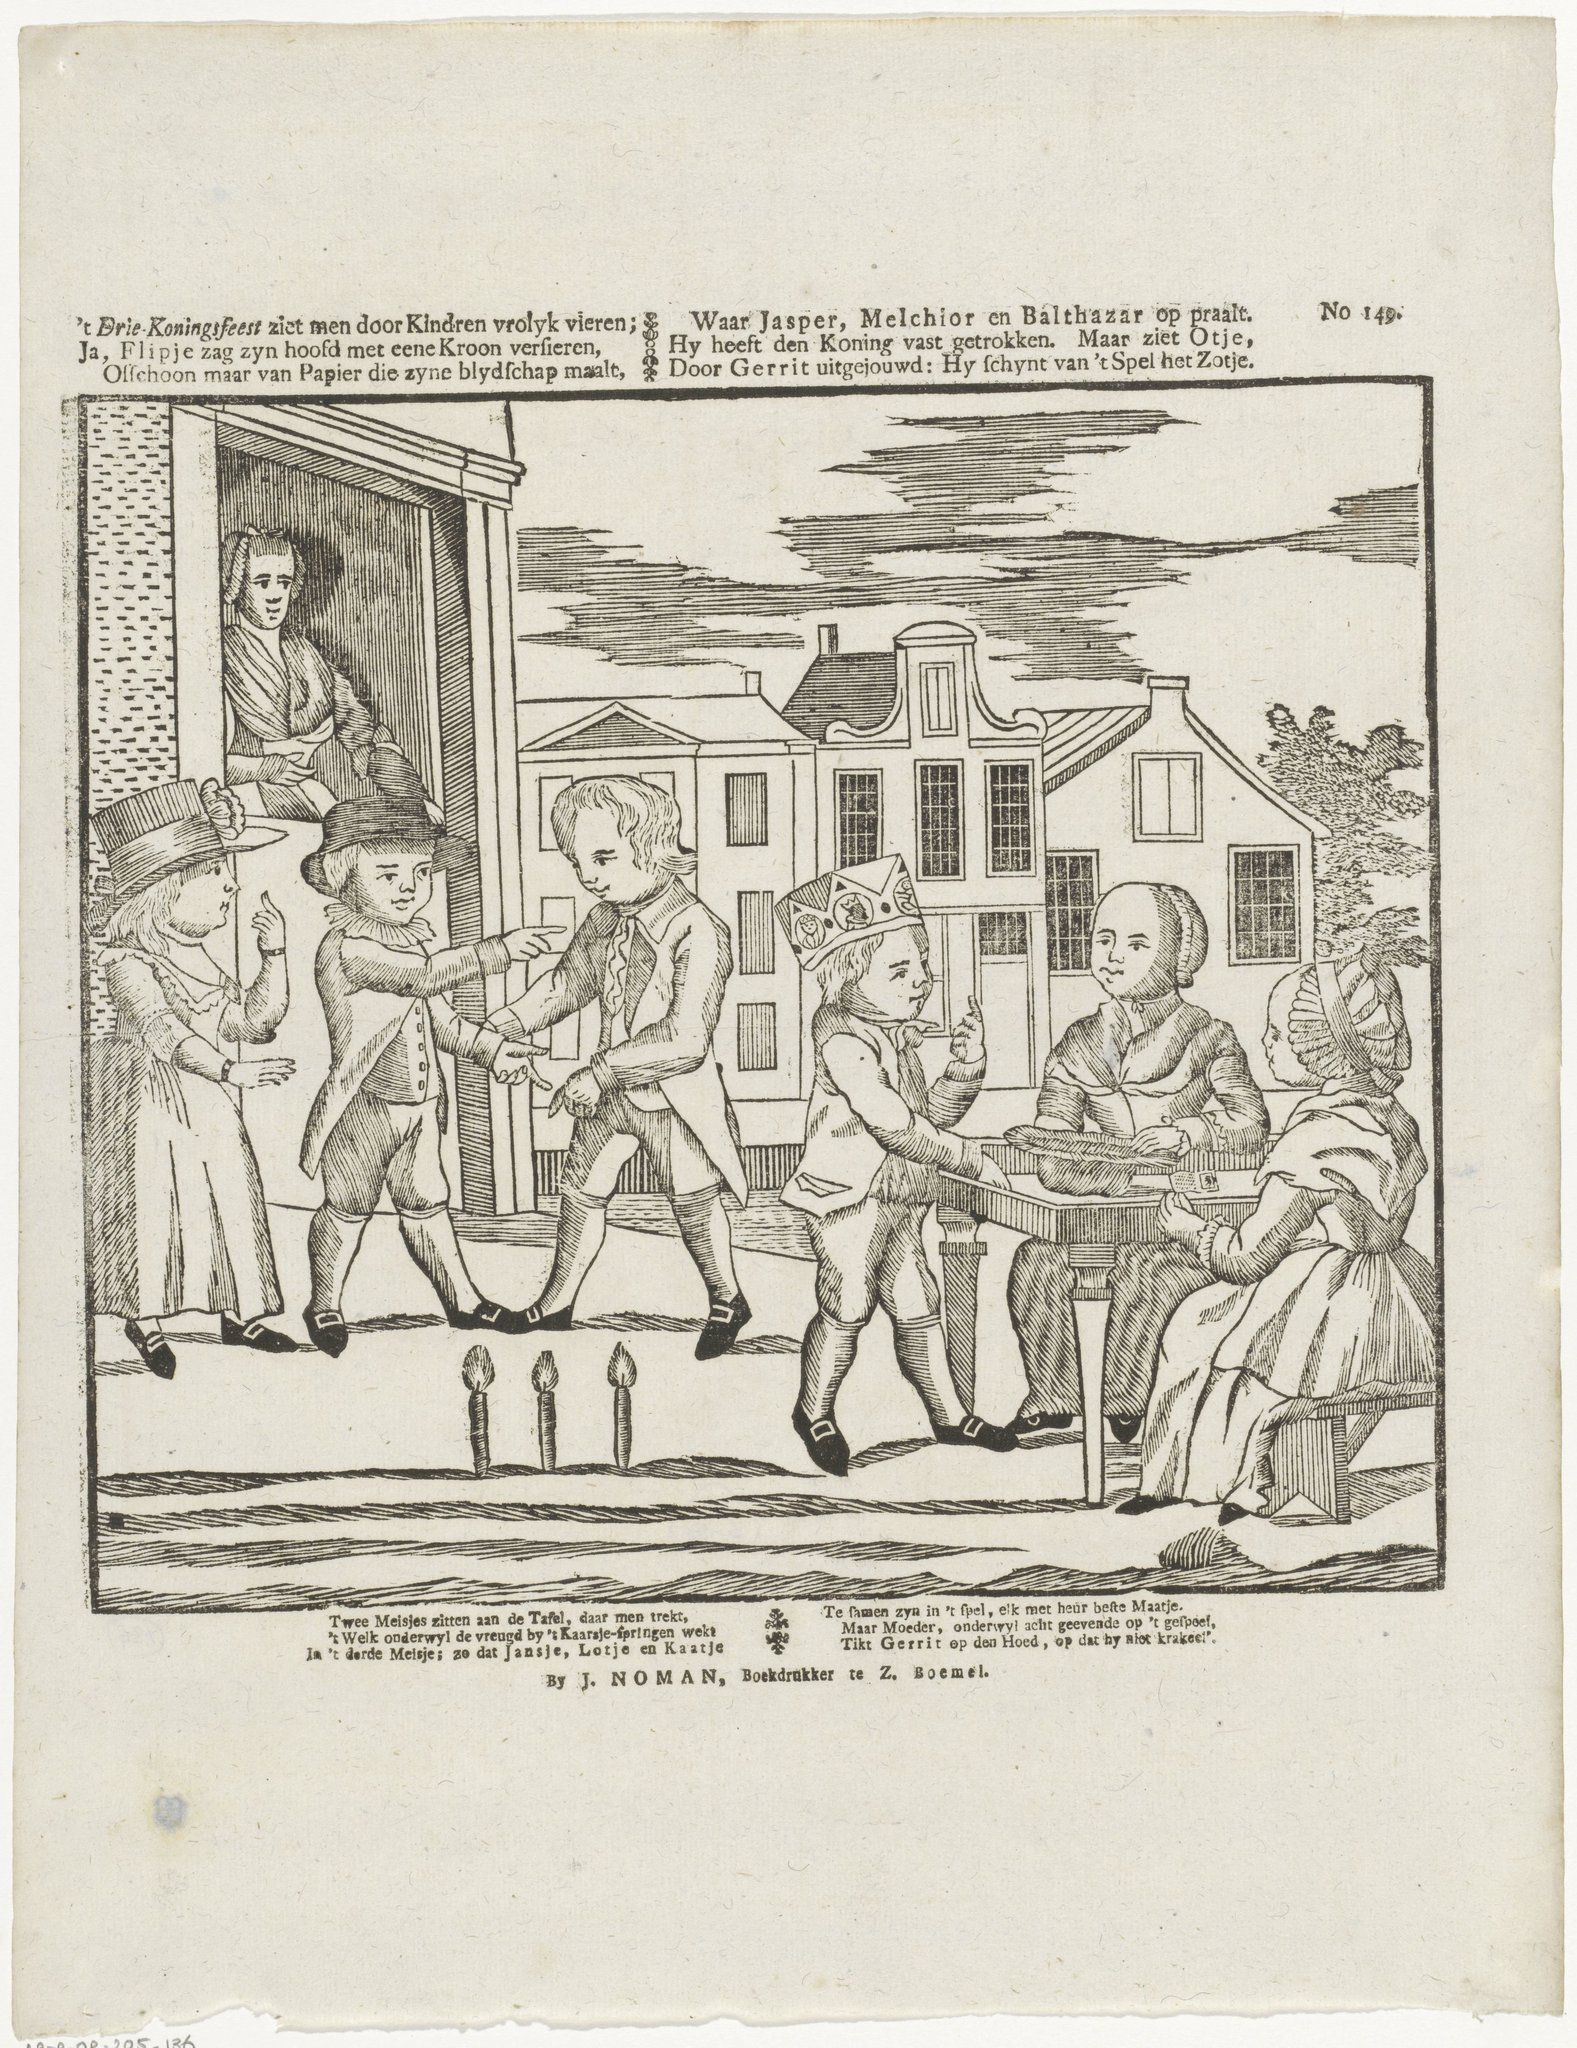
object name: popular print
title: 't Drie-koningsfeest ziet men door kindren vrolyk vieren; / Ja, Flipje zag zyn hoofd met eenen kroon versieren [(...)]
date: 1806-1830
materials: paper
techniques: letterpress printing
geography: netherlands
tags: children's games and plays, twelfth night, usually falling on the eve of january 6, royal household; courtiers, retinue, train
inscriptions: collector's mark: Lugt 2760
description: Blad met een grote voorstelling van zes kinderen die het spel koning-trekken spelen op het Driekoningenfeest. Moeder kijkt vanaf een afstandje toe. Onder de afbeelding een zesregelig vers in twee kolommen. Genummerd rechtsboven: No 149.